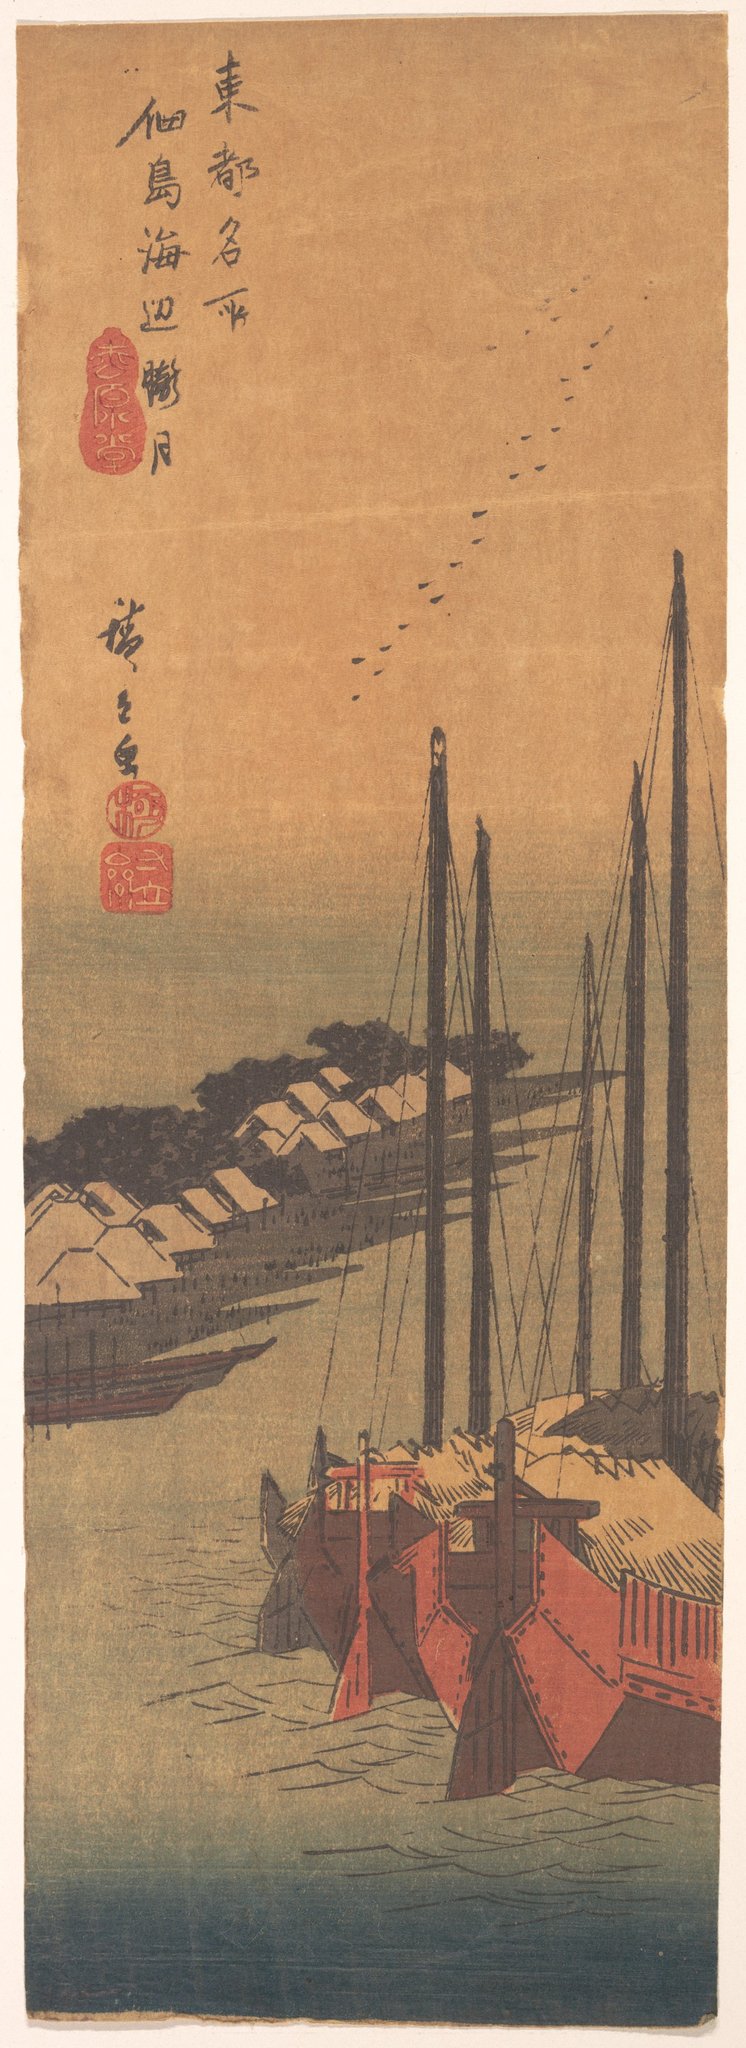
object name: print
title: Tsukudajima no Oborozuki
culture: japanese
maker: utagawa hiroshige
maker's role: artist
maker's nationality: japanese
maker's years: 1797-1858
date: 1797-1858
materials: ink, paper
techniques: woodblock print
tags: boats